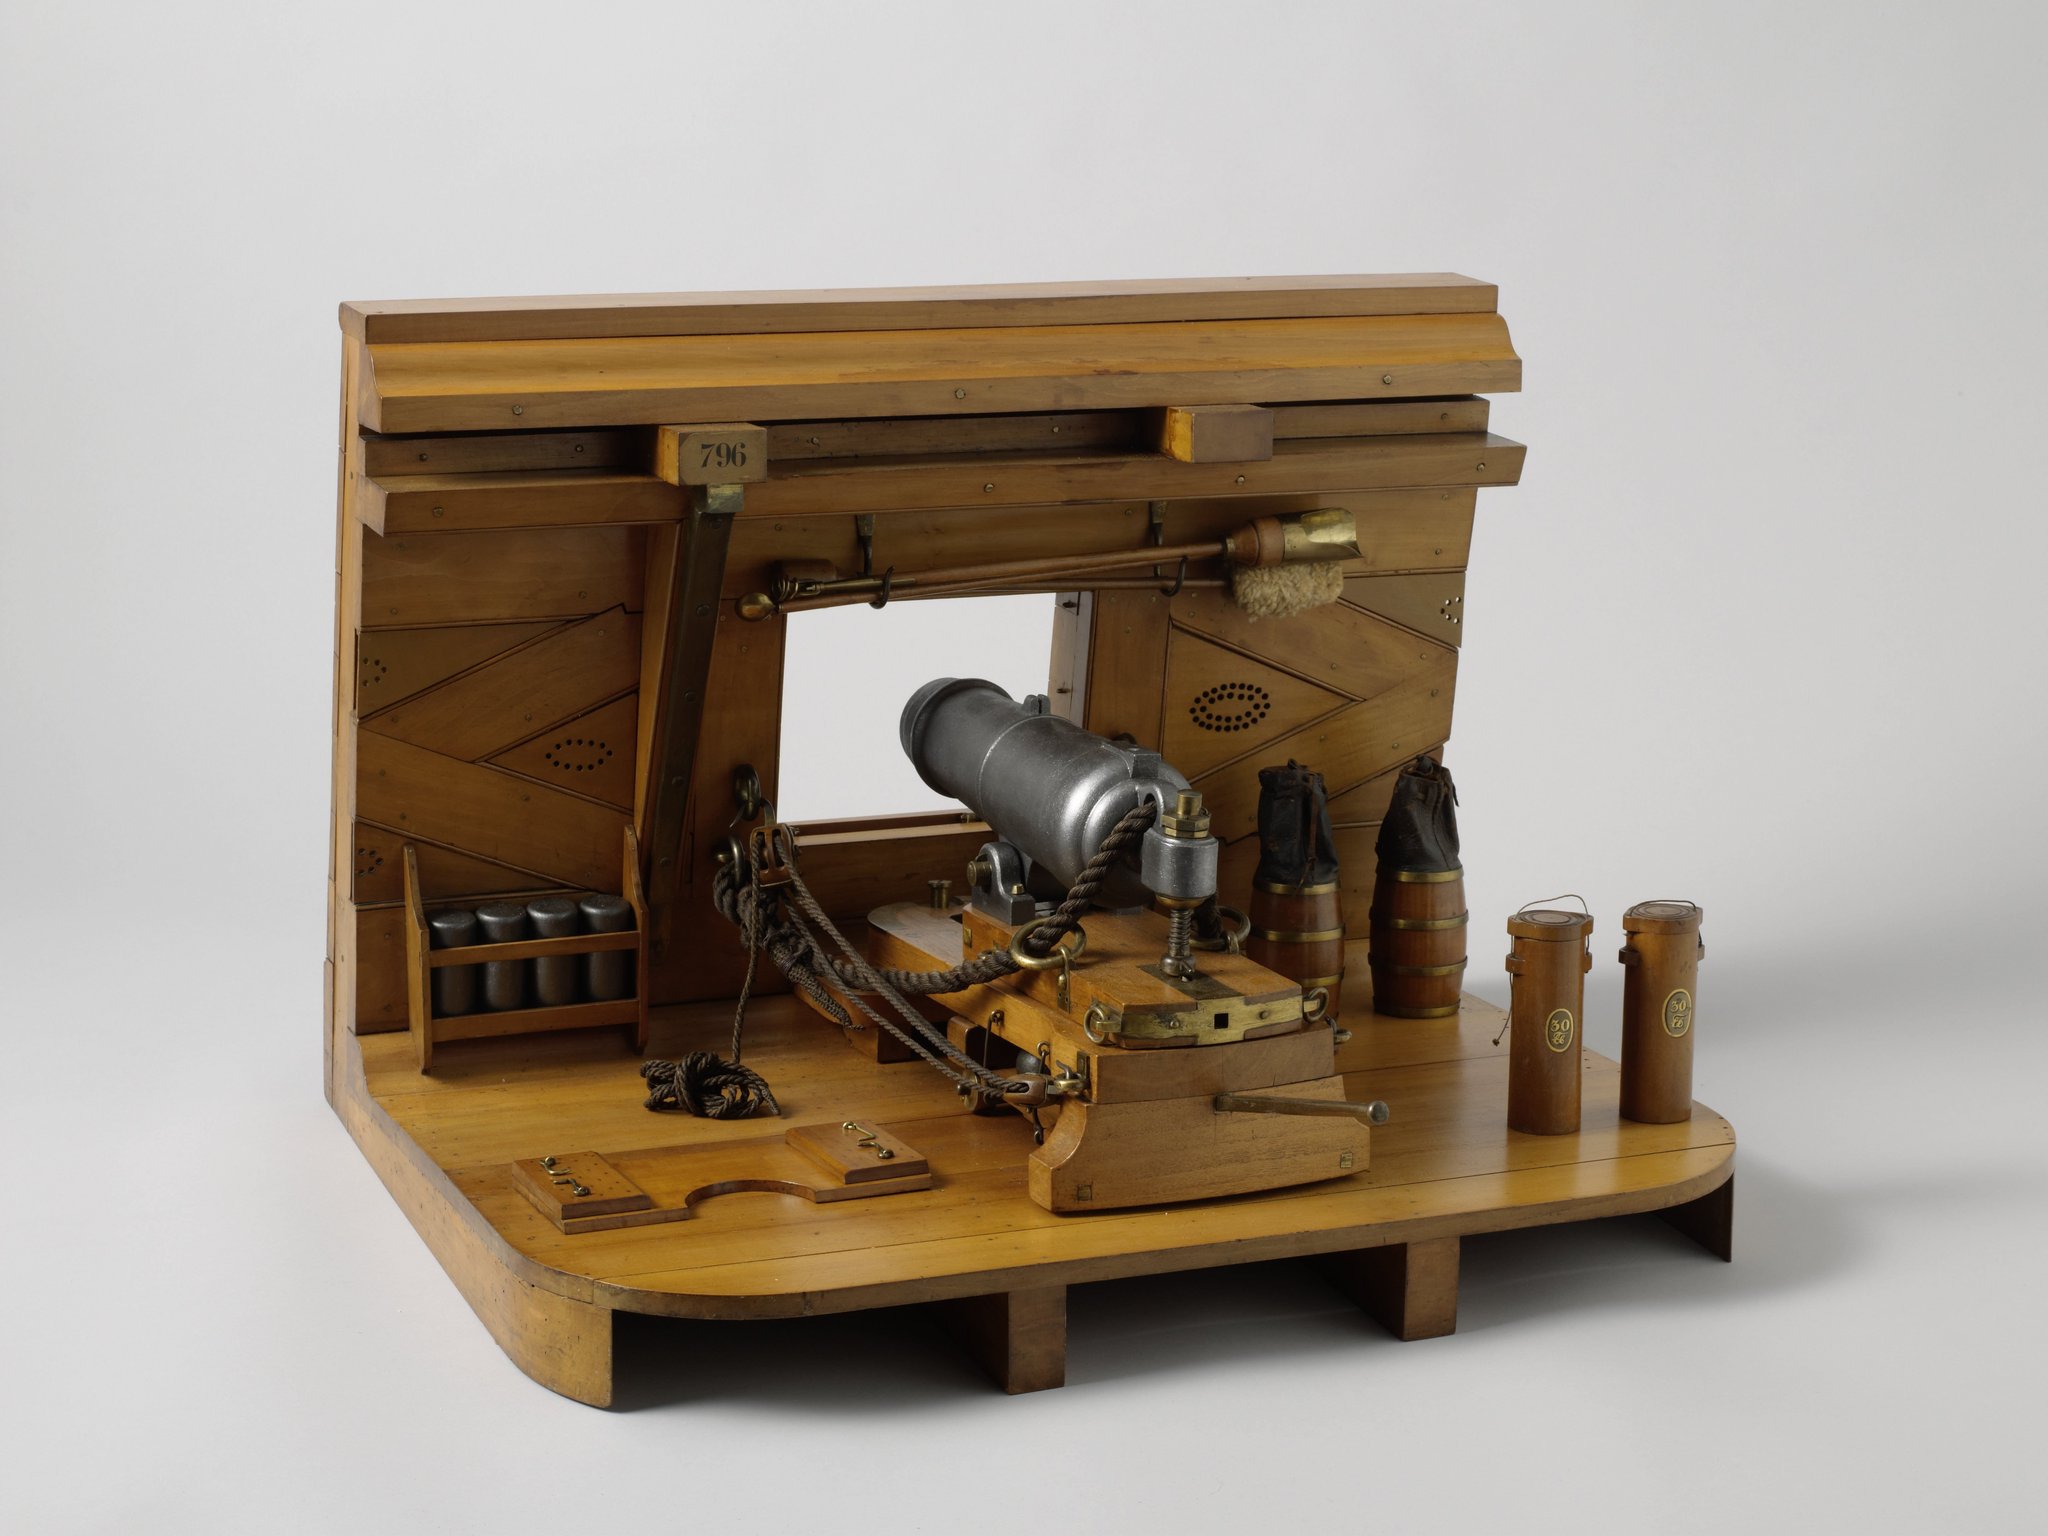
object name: gunmodel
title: Model of a 30-pounder carronade in a battery Vlissingen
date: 1838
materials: brass, leather, paint, fiber, wood, wool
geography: flushing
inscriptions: label, on the part of the ship: ‘796’ former inventory label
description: The carronade was invented by the Carron ironworks in Scotland. In English, the weapon was commonly known as a ‘smasher’, owing to its devastating power at close range. Thanks to its modest dimensions and sliding mount to absorb recoil, this short cannon could also be deployed on smaller ships. The model displays all the requisite accessories: an ammunition rack, powder horns, pouch-topped powder kegs, shrapnel shells and cartridge cases.